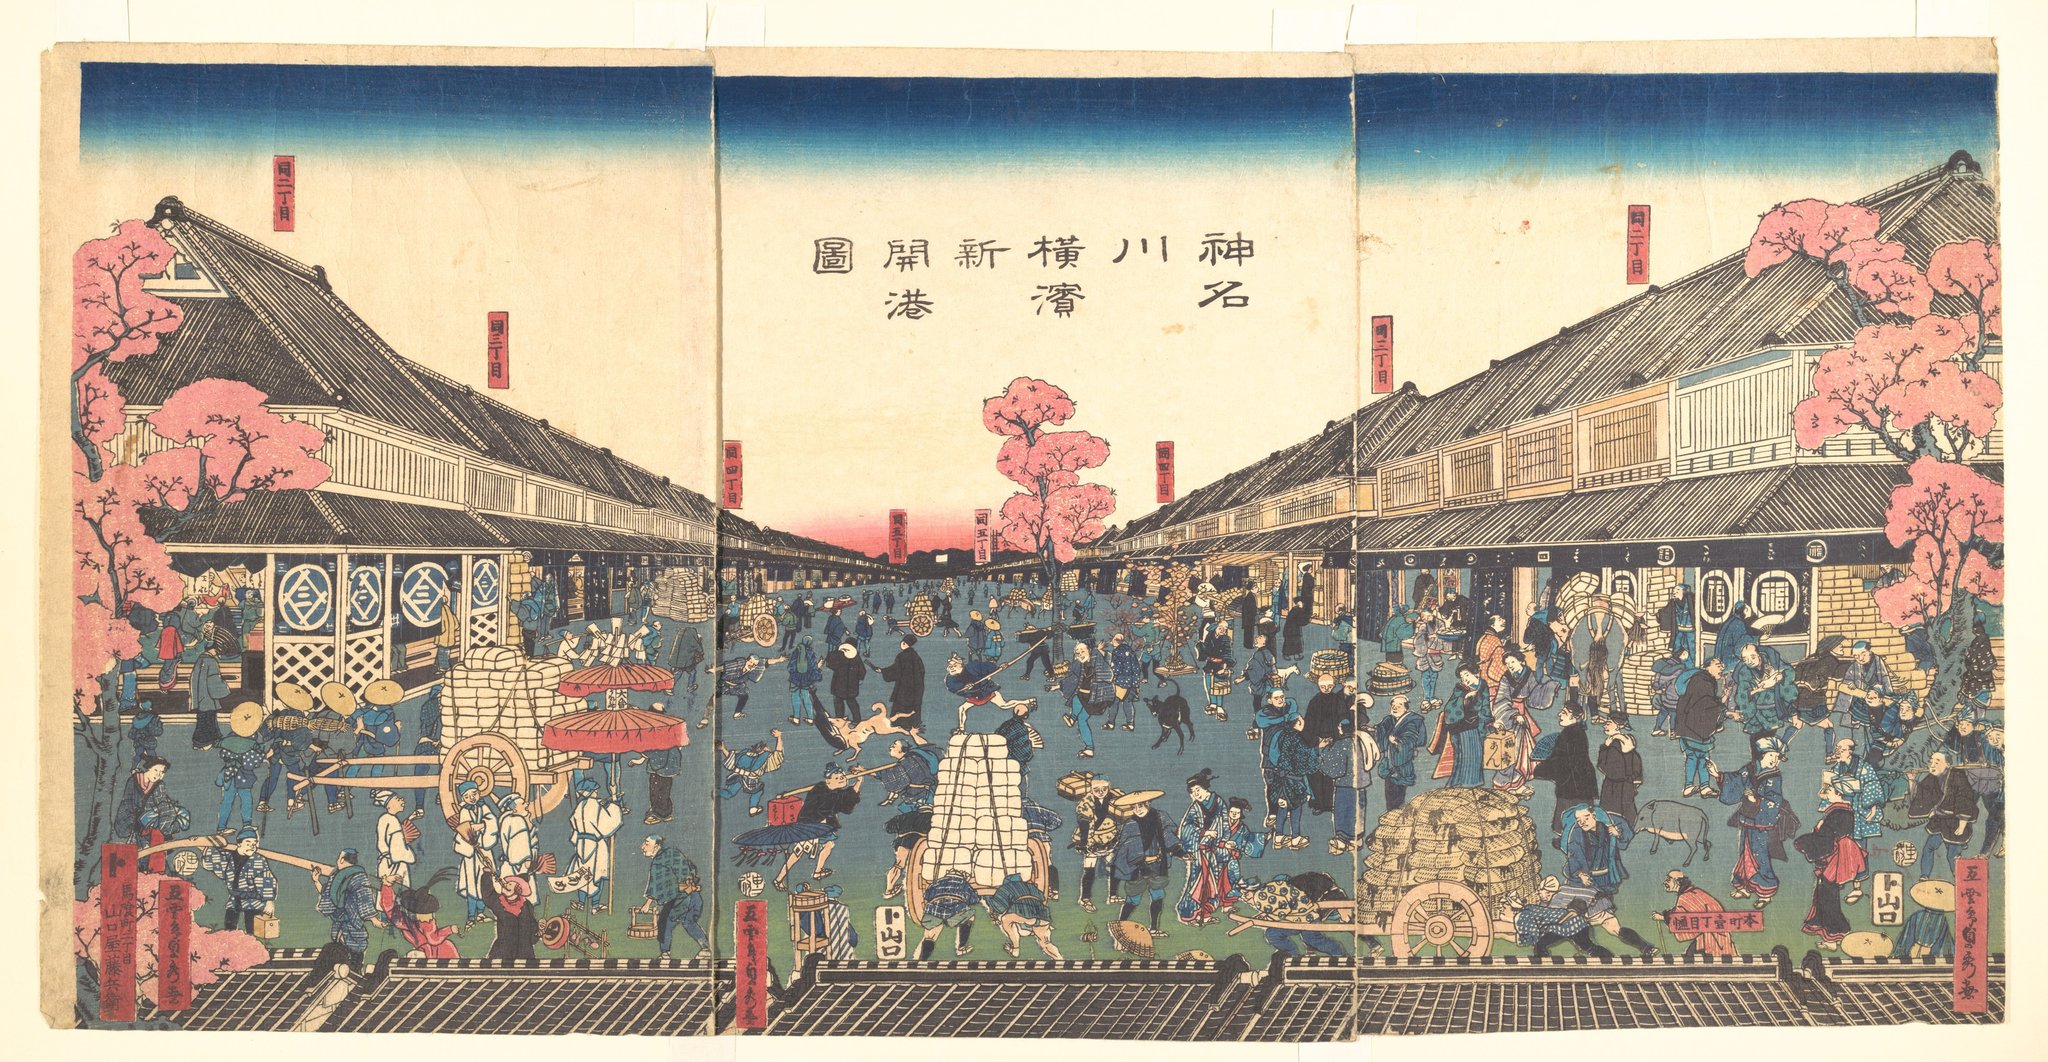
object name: print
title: The Newly Opened Port of Yokohama in Kanagawa Prefecture (Kanagawa Yokohama shinkaikōzu)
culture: japanese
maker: utagawa (gountei) sadahide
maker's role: artist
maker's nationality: japanese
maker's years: 1807-1873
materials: ink, paper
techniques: nishiki e, woodblock print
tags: dogs,crowd,markets,carts